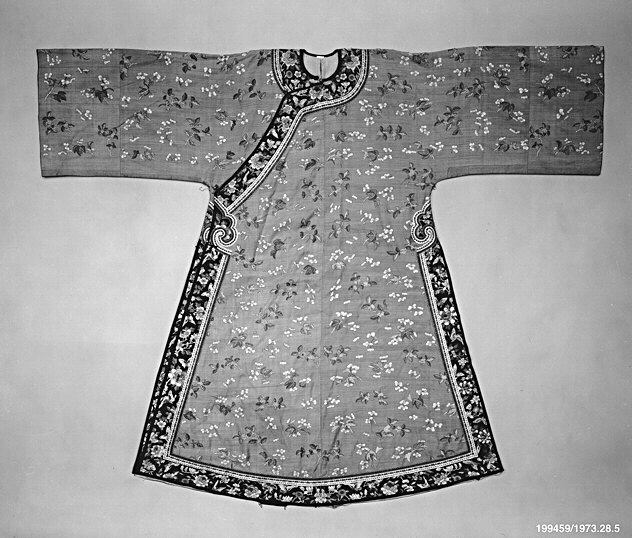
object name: woman's informal robe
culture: chinese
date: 1801-1900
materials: metal thread, silk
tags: flowers